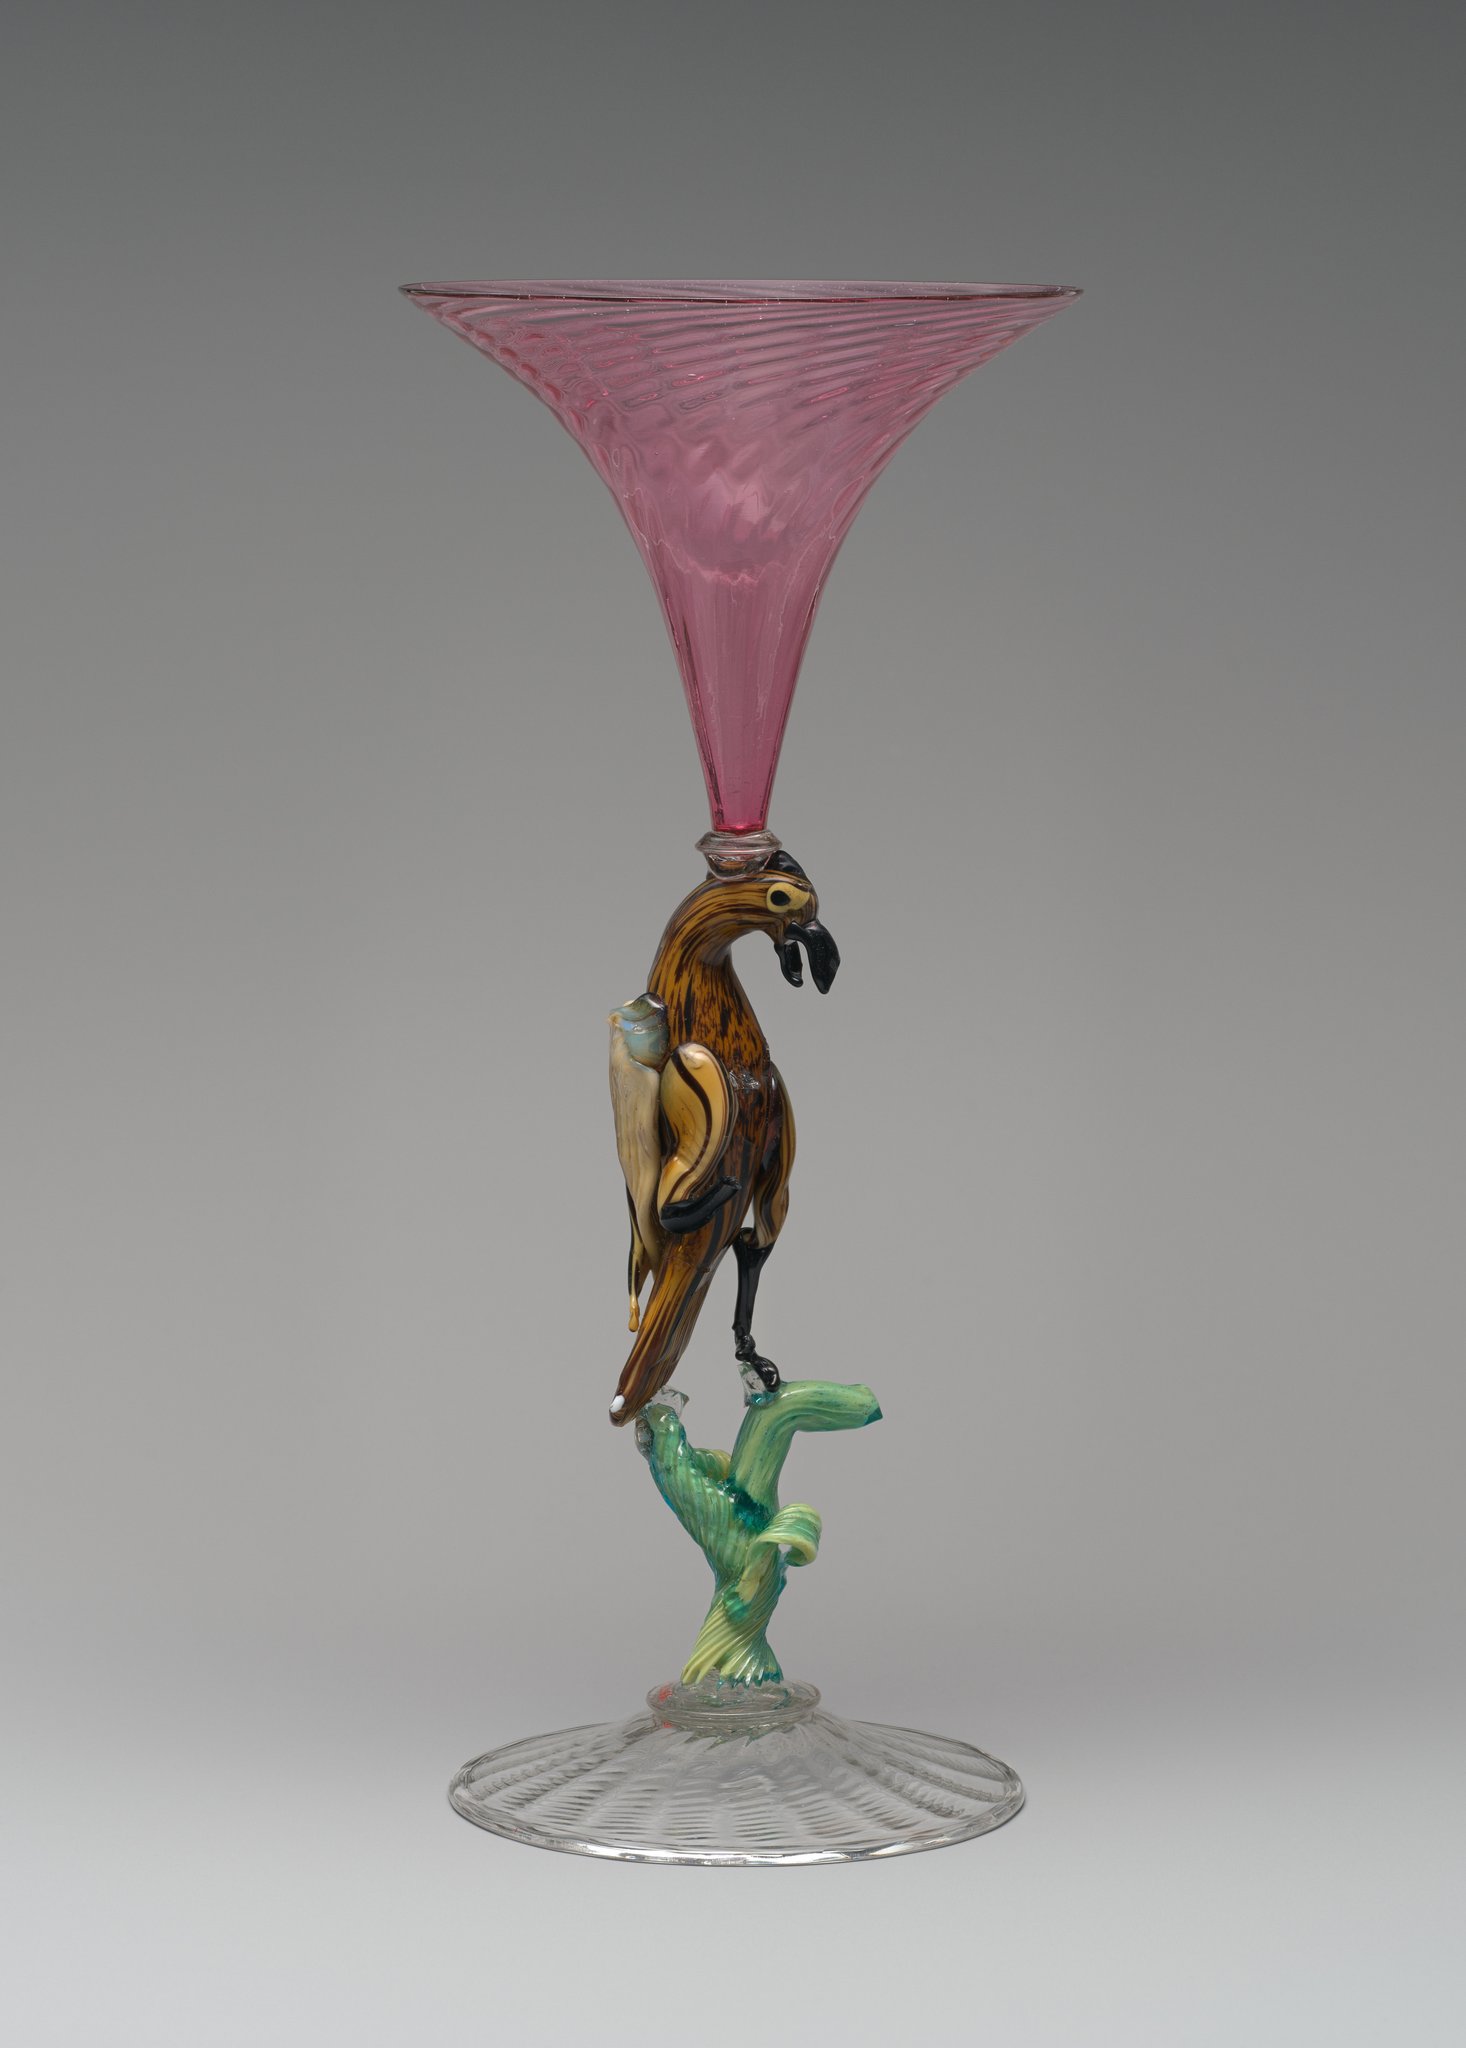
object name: wineglass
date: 1801-1900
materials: glass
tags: birds